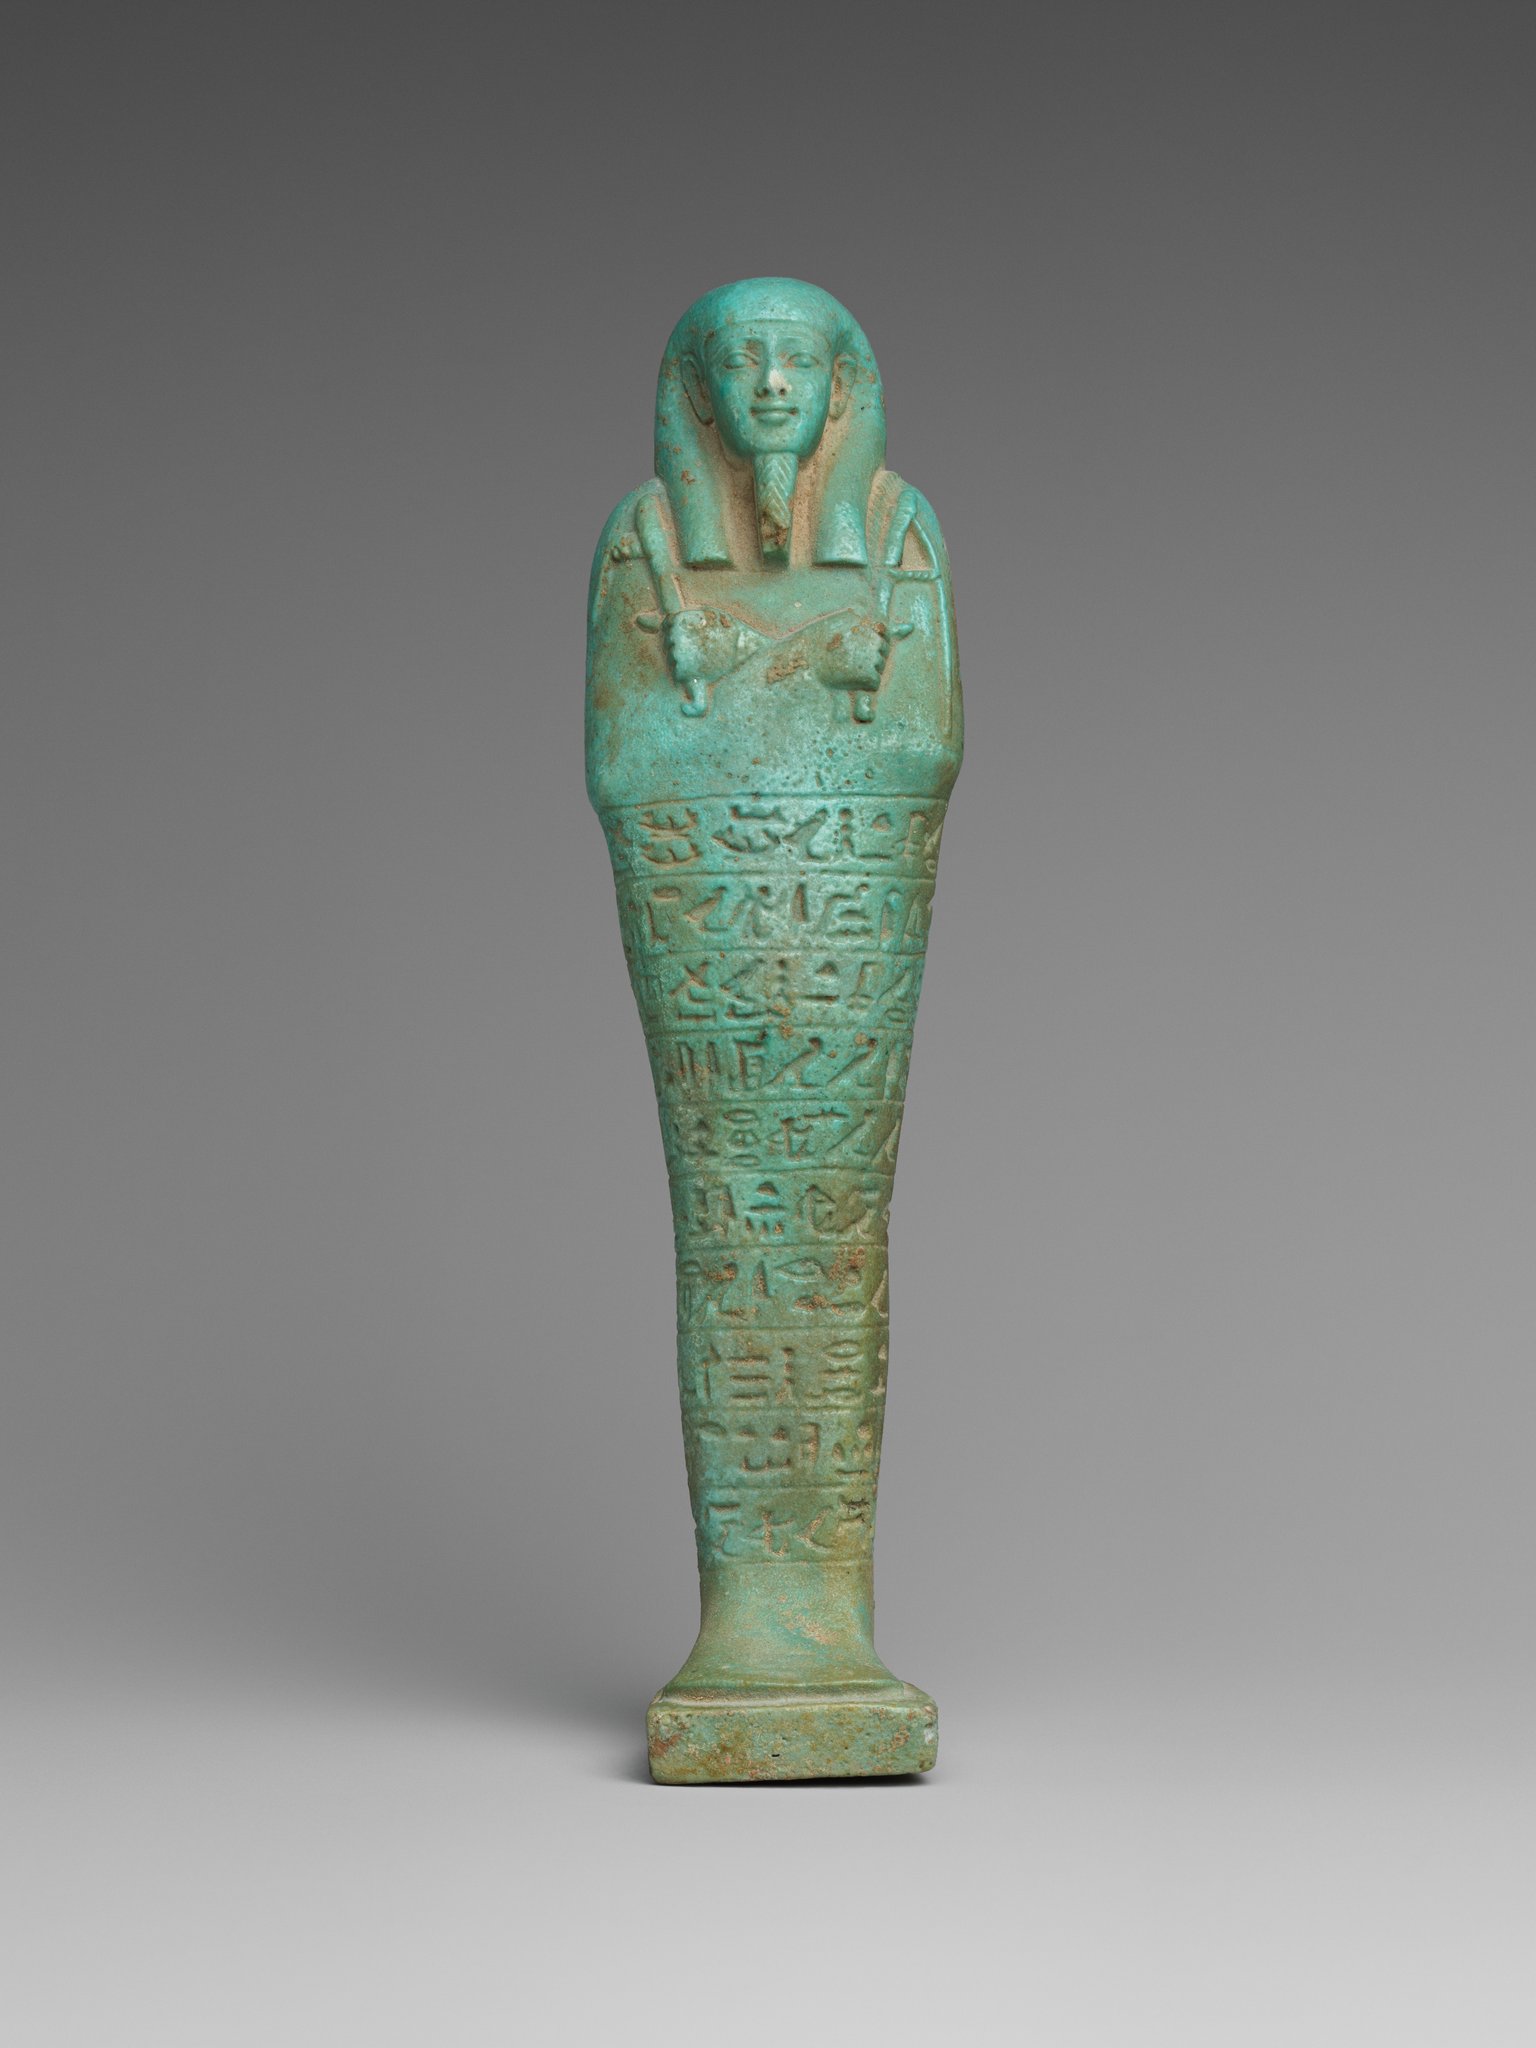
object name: shabti, tjanenhebu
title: Shabti of the Commander of the Royal Fleet Tjanenhebu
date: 570-526 BCE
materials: faience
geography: egypt